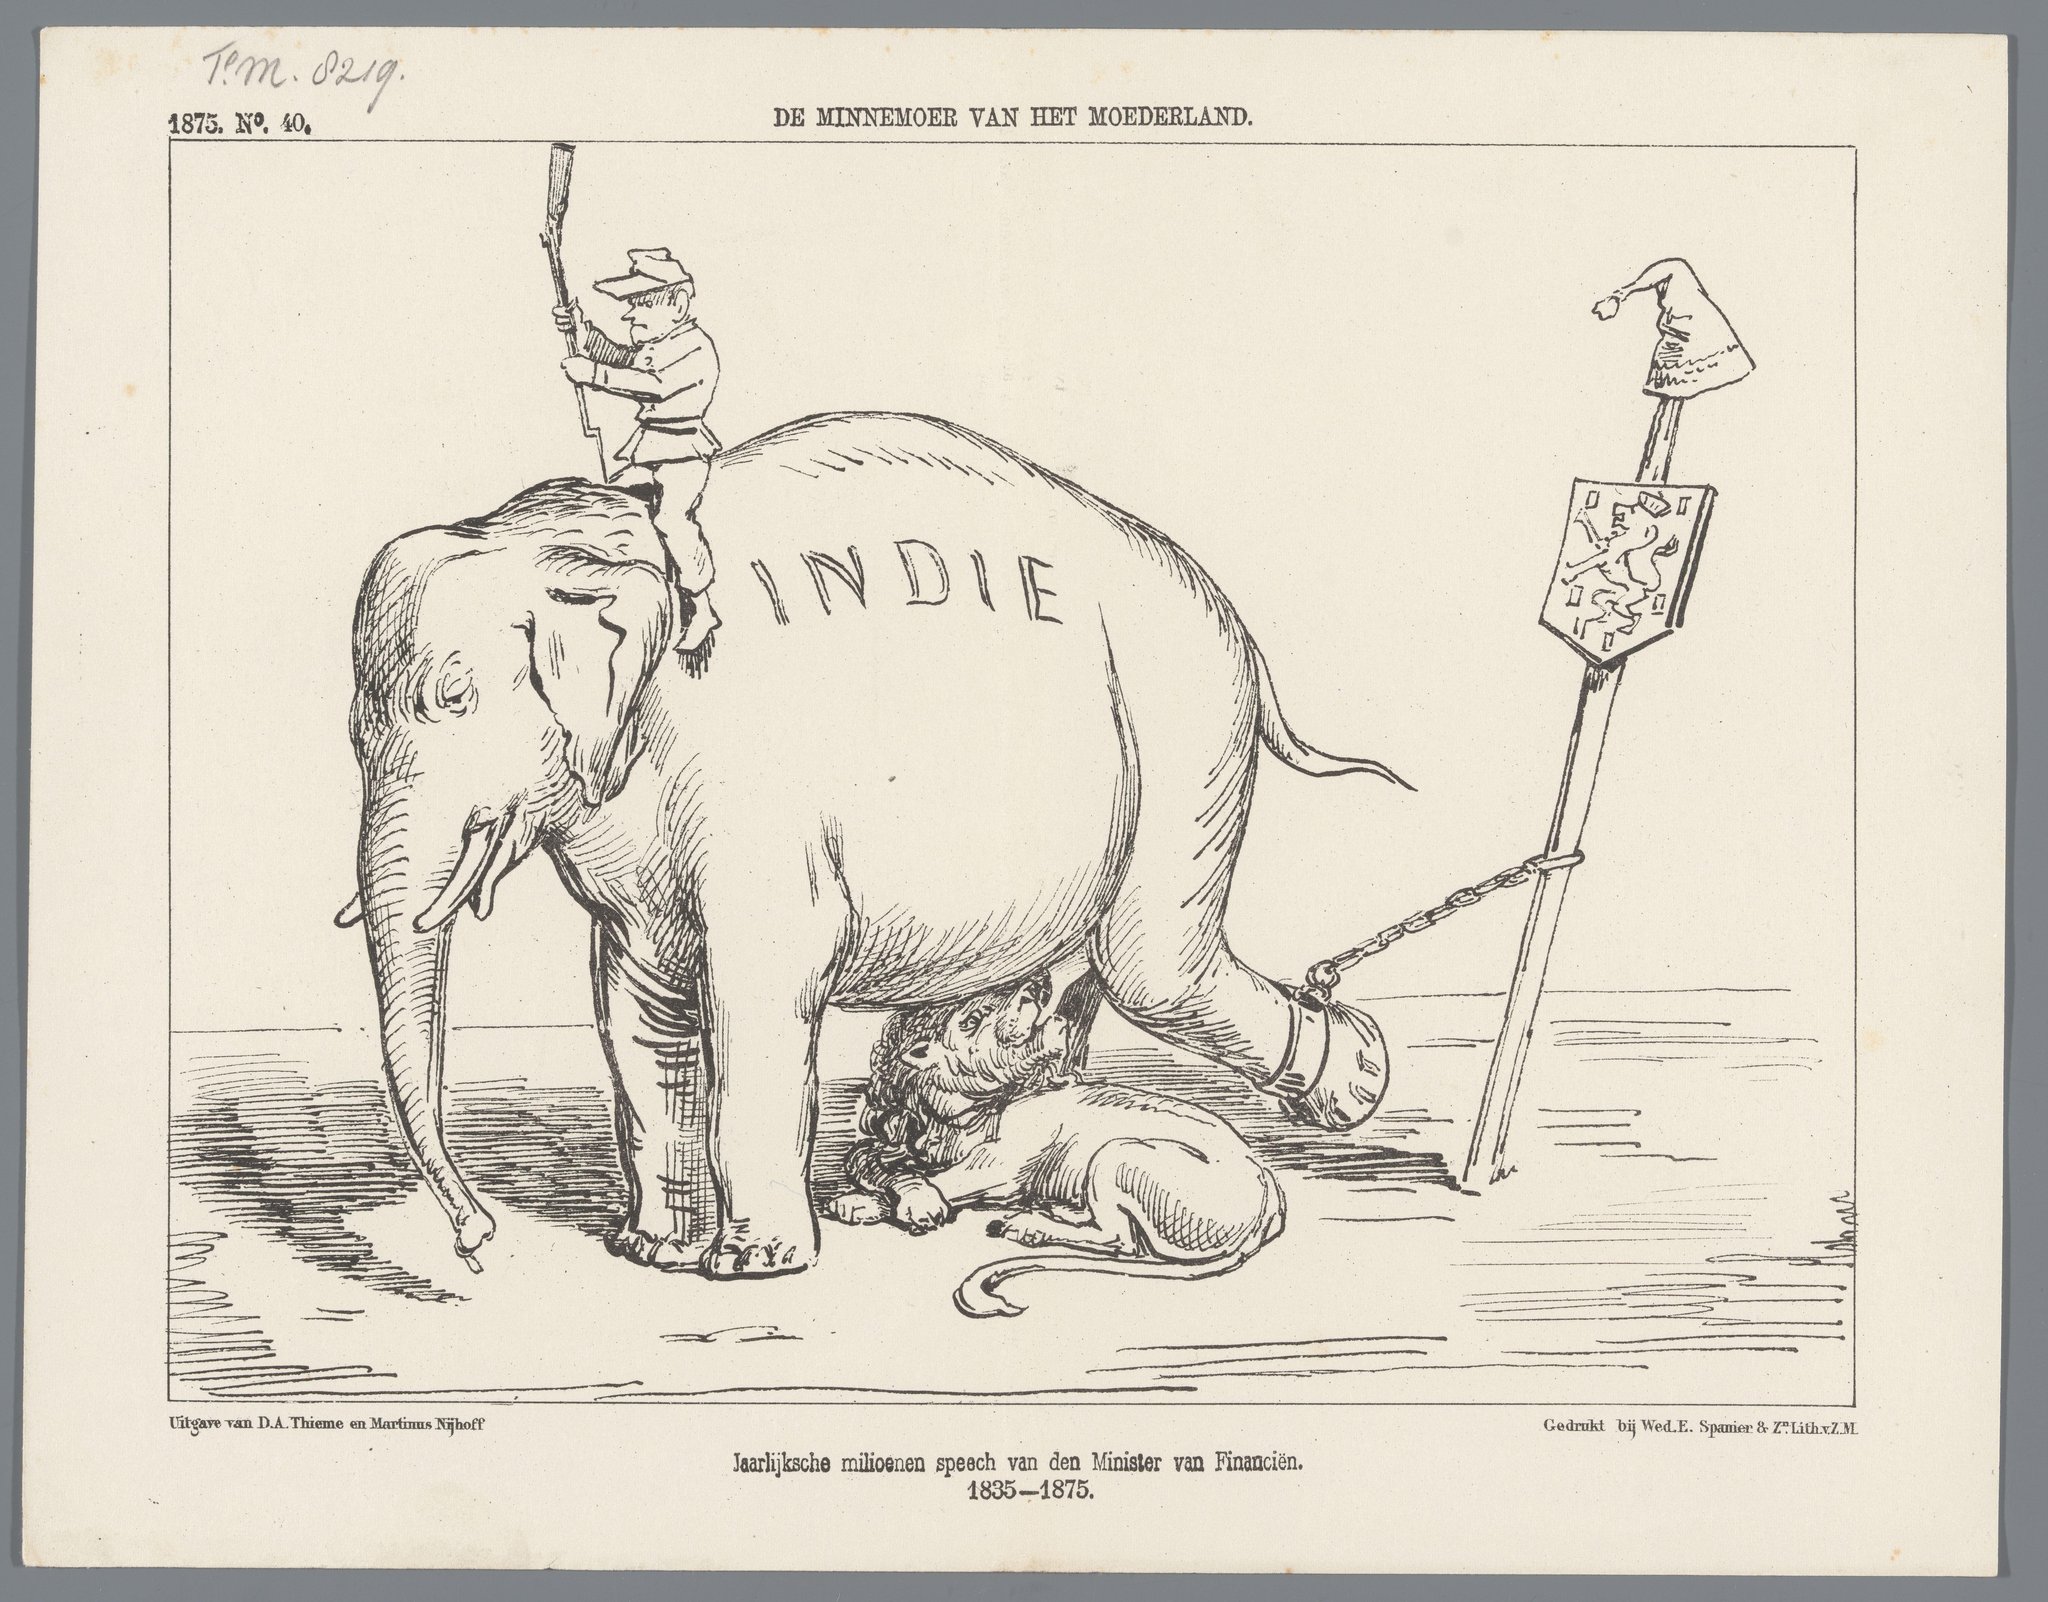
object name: print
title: De minnemoer van het moederland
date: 1875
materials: paper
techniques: lithograph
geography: arnhem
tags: dutch east indies, the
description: De Nederlandse Leeuw gezoogd door een olifant. Spotprent op de Indische baten, 1875. Plaat verschenen bij het weekblad De Nederlandsche Spectator, nr. 40, 1875.